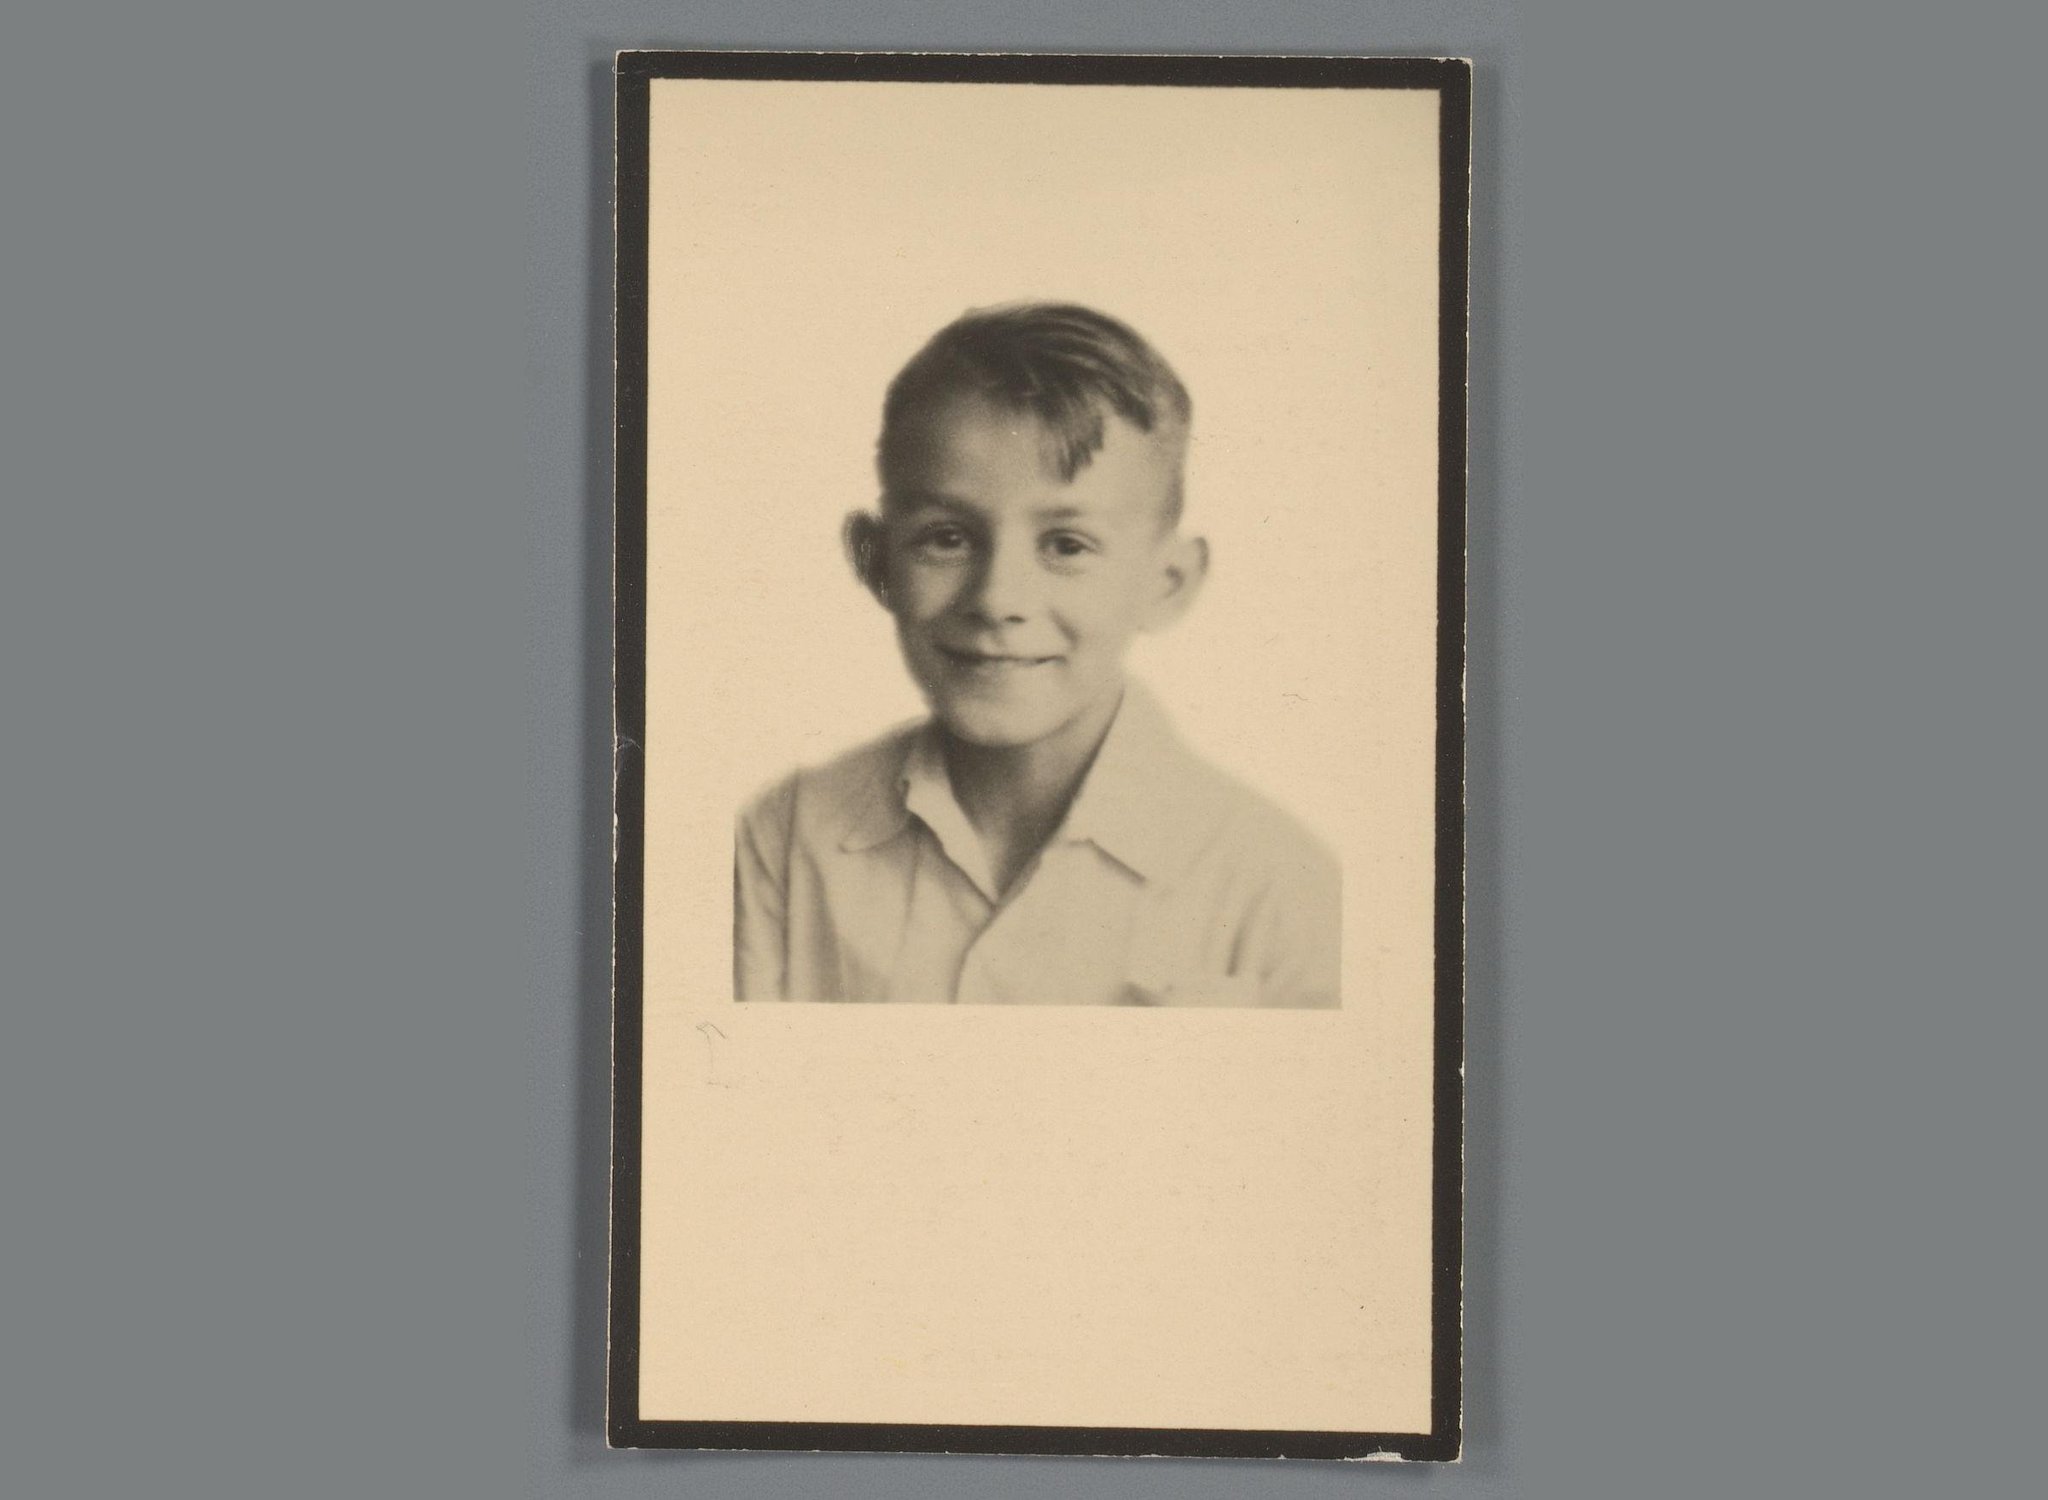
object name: photograph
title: Portret van Josje Westerweel op bidprent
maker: Anonymous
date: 1949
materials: paper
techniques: gelatin silver print, letterpress printing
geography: bussum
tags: boy (child between toddler and youth), historical persons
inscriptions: inscription: ‘Bidt voor onze lieve Josje Westerweel, geboren (...) Mijn kleine hartje winnen kon.’